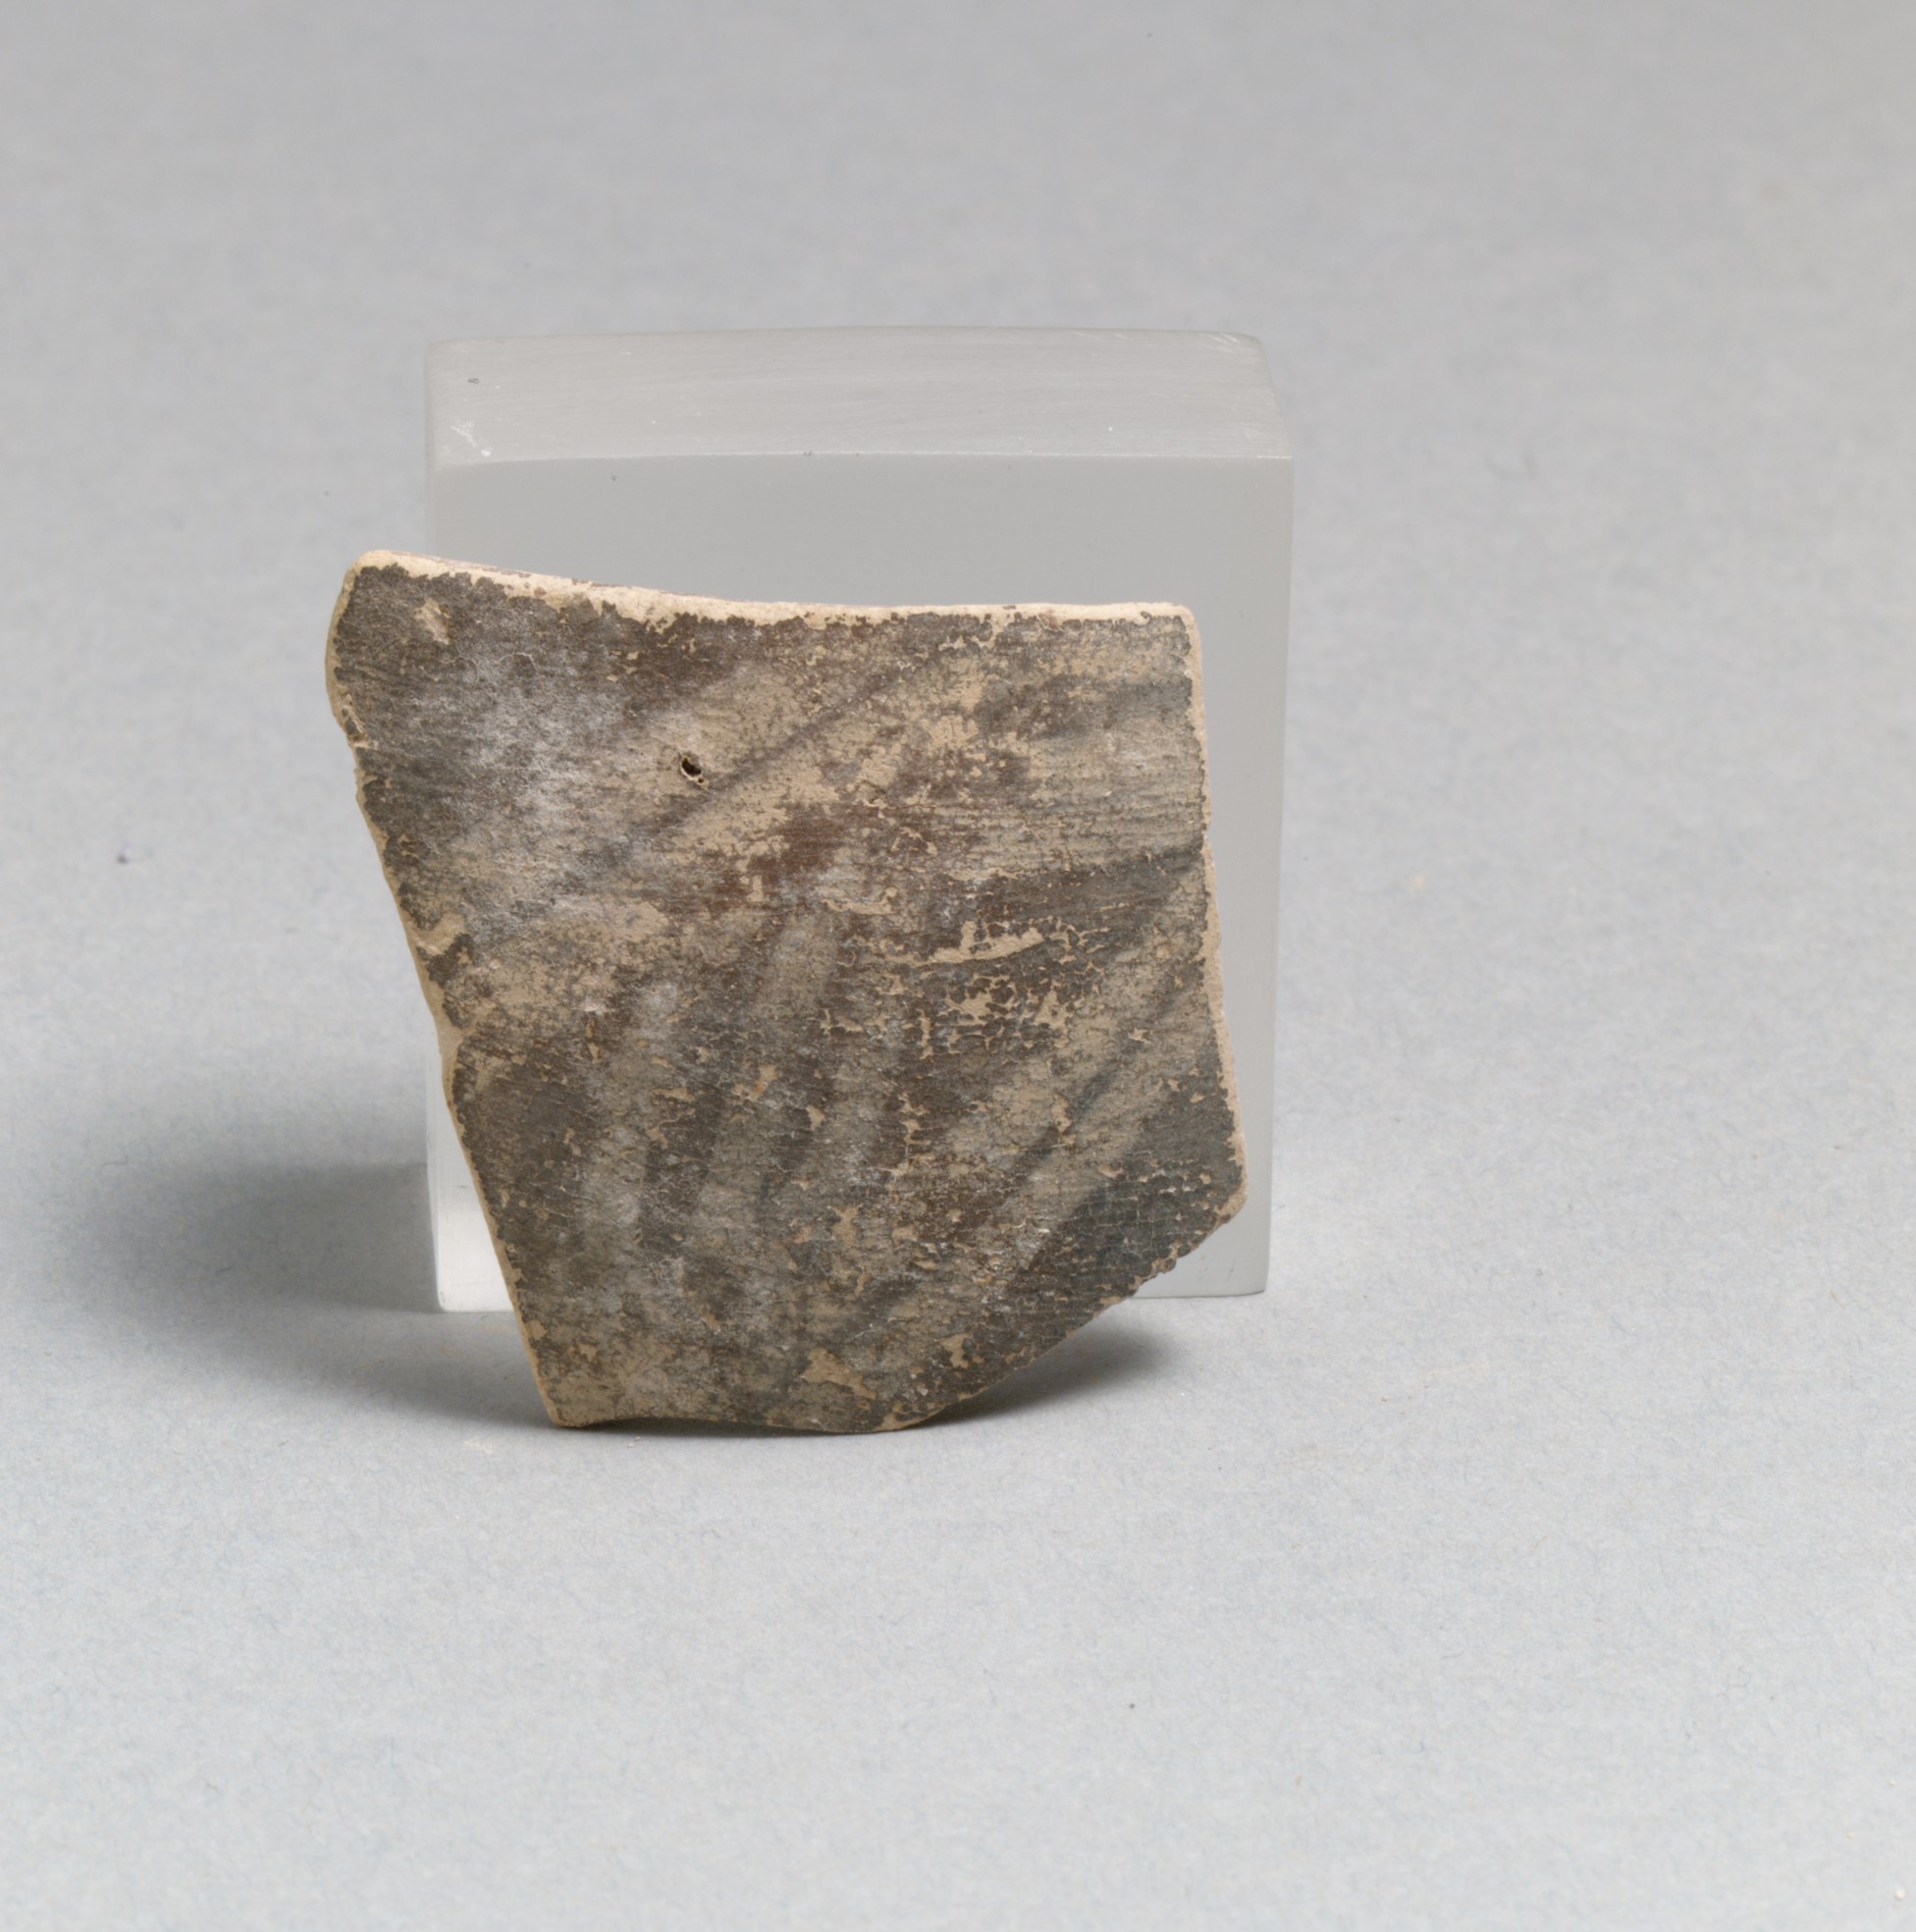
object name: vase fragment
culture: minoan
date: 2600-2000 BCE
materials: terracotta